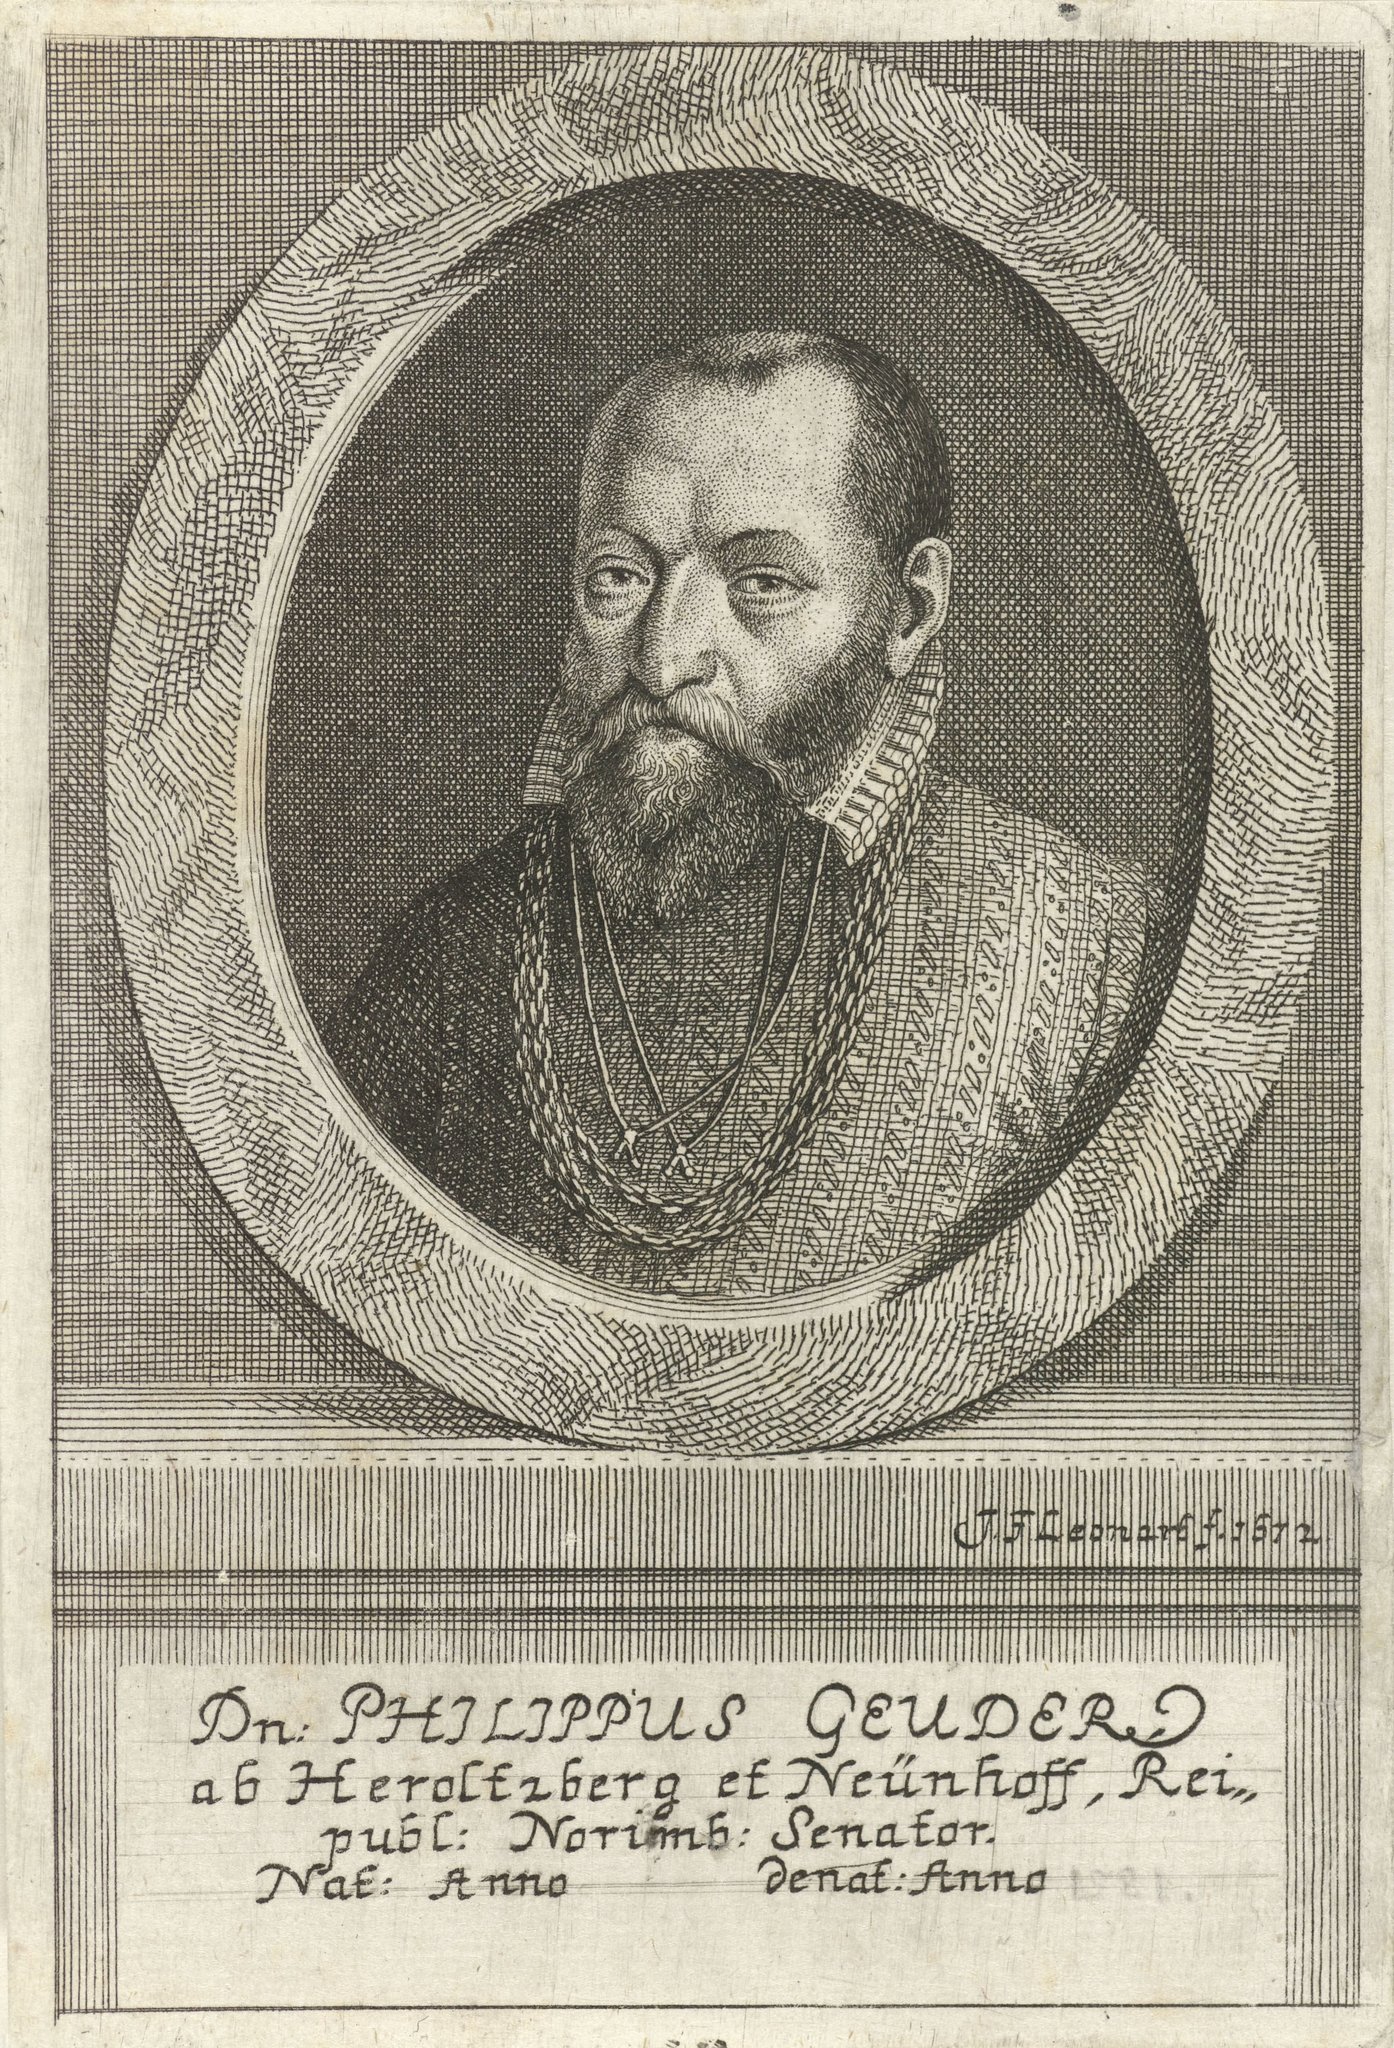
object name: print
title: Portret van Philippus Geuder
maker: johann friedrich leonard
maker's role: print maker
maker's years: 1633-1680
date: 1672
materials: paper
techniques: engraving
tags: senator, philippus geuder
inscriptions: collector's mark: Lugt 1337, collector's mark: Lugt 2228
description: Portret van Philippus Geuder, senator te Neurenberg.